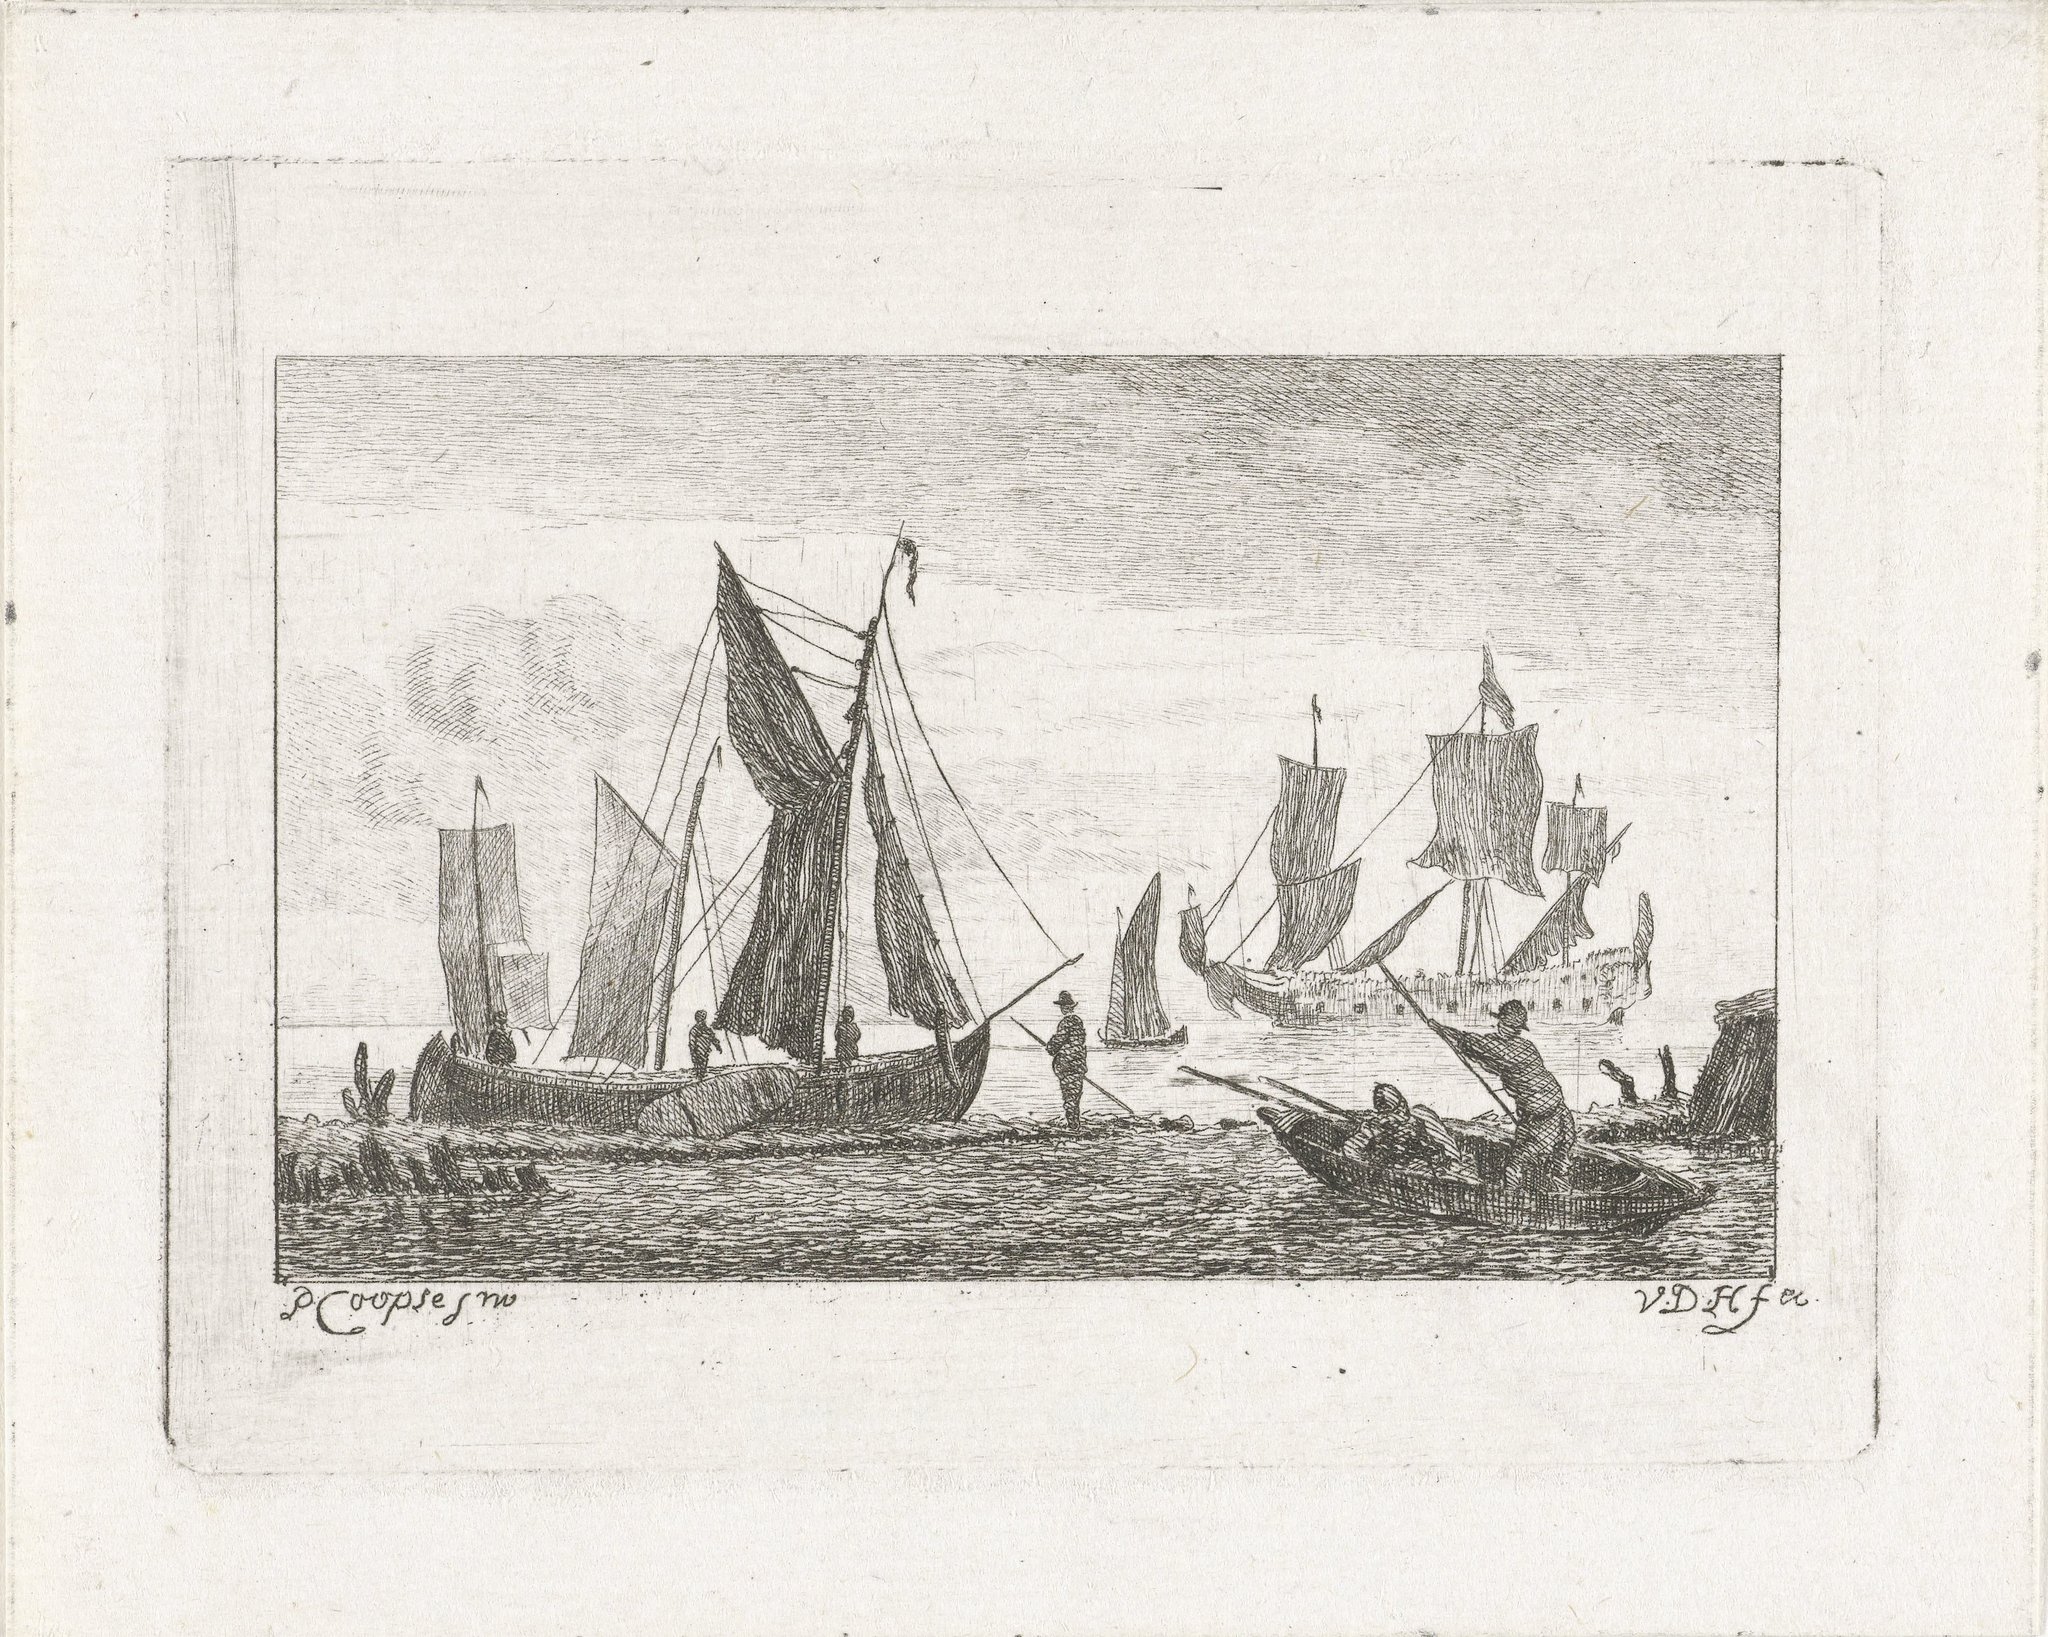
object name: print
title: Zeilschepen op het water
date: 1745-1785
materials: paper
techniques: etching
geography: northern netherlands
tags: sailing-ship, sailing-boat, rowing-boat, canoe, etc., landscapes with waters, waterscapes, seascapes (in the temperate zone) (+ landscape with figures, staffage)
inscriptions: collector's mark: Lugt 240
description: Zeilschepen op het water met rechts een roeiboot.